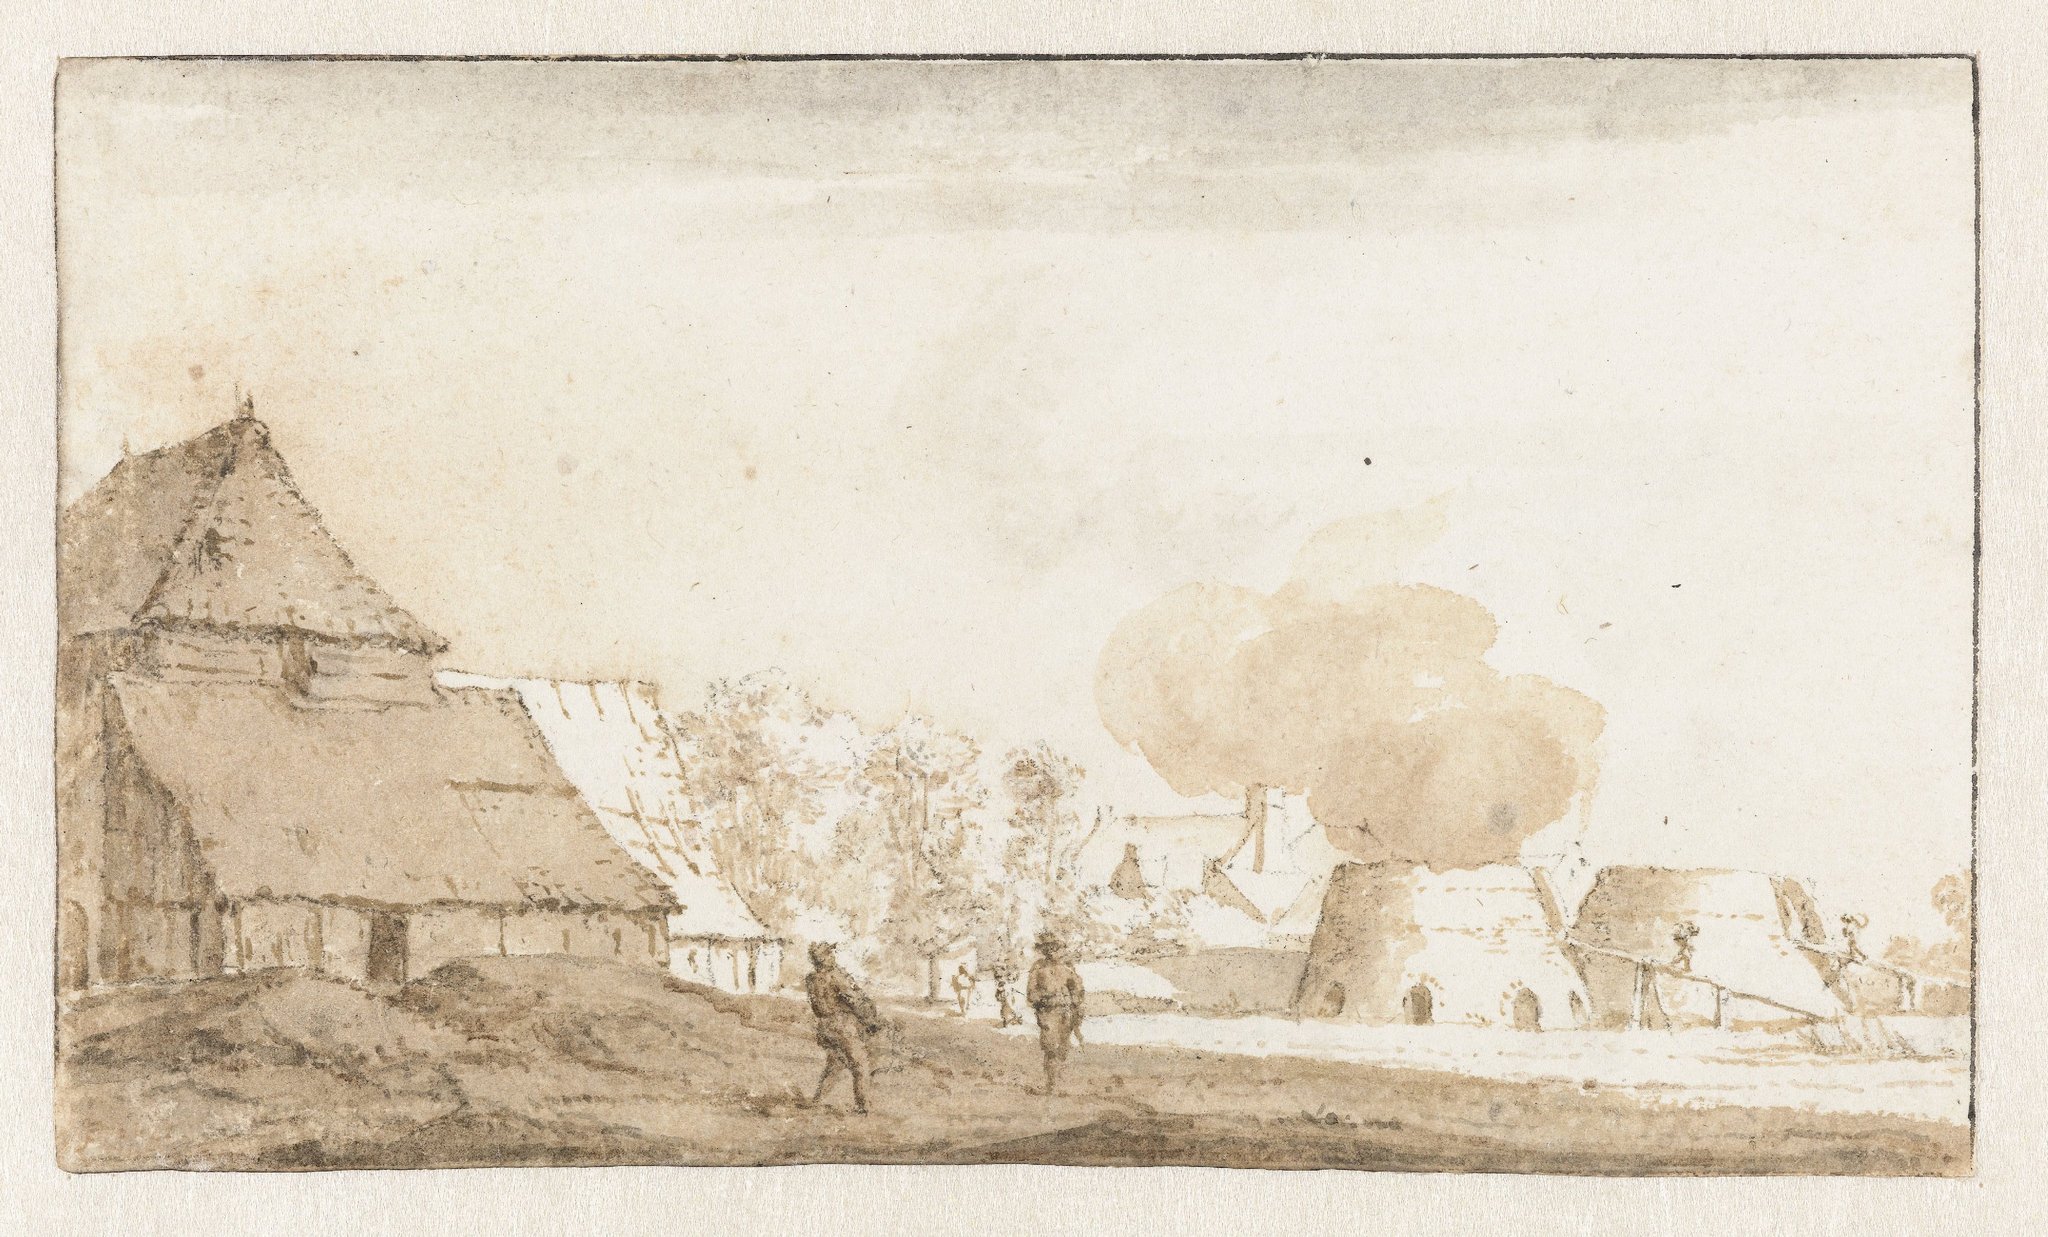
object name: drawing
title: Kalkovens bij Leiderdorp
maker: jan de bisschop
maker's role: draughtsman, print maker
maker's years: 1628-1671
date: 1648-1671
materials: chalk, paper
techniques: brush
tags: factory-building, lime works, lime-burner